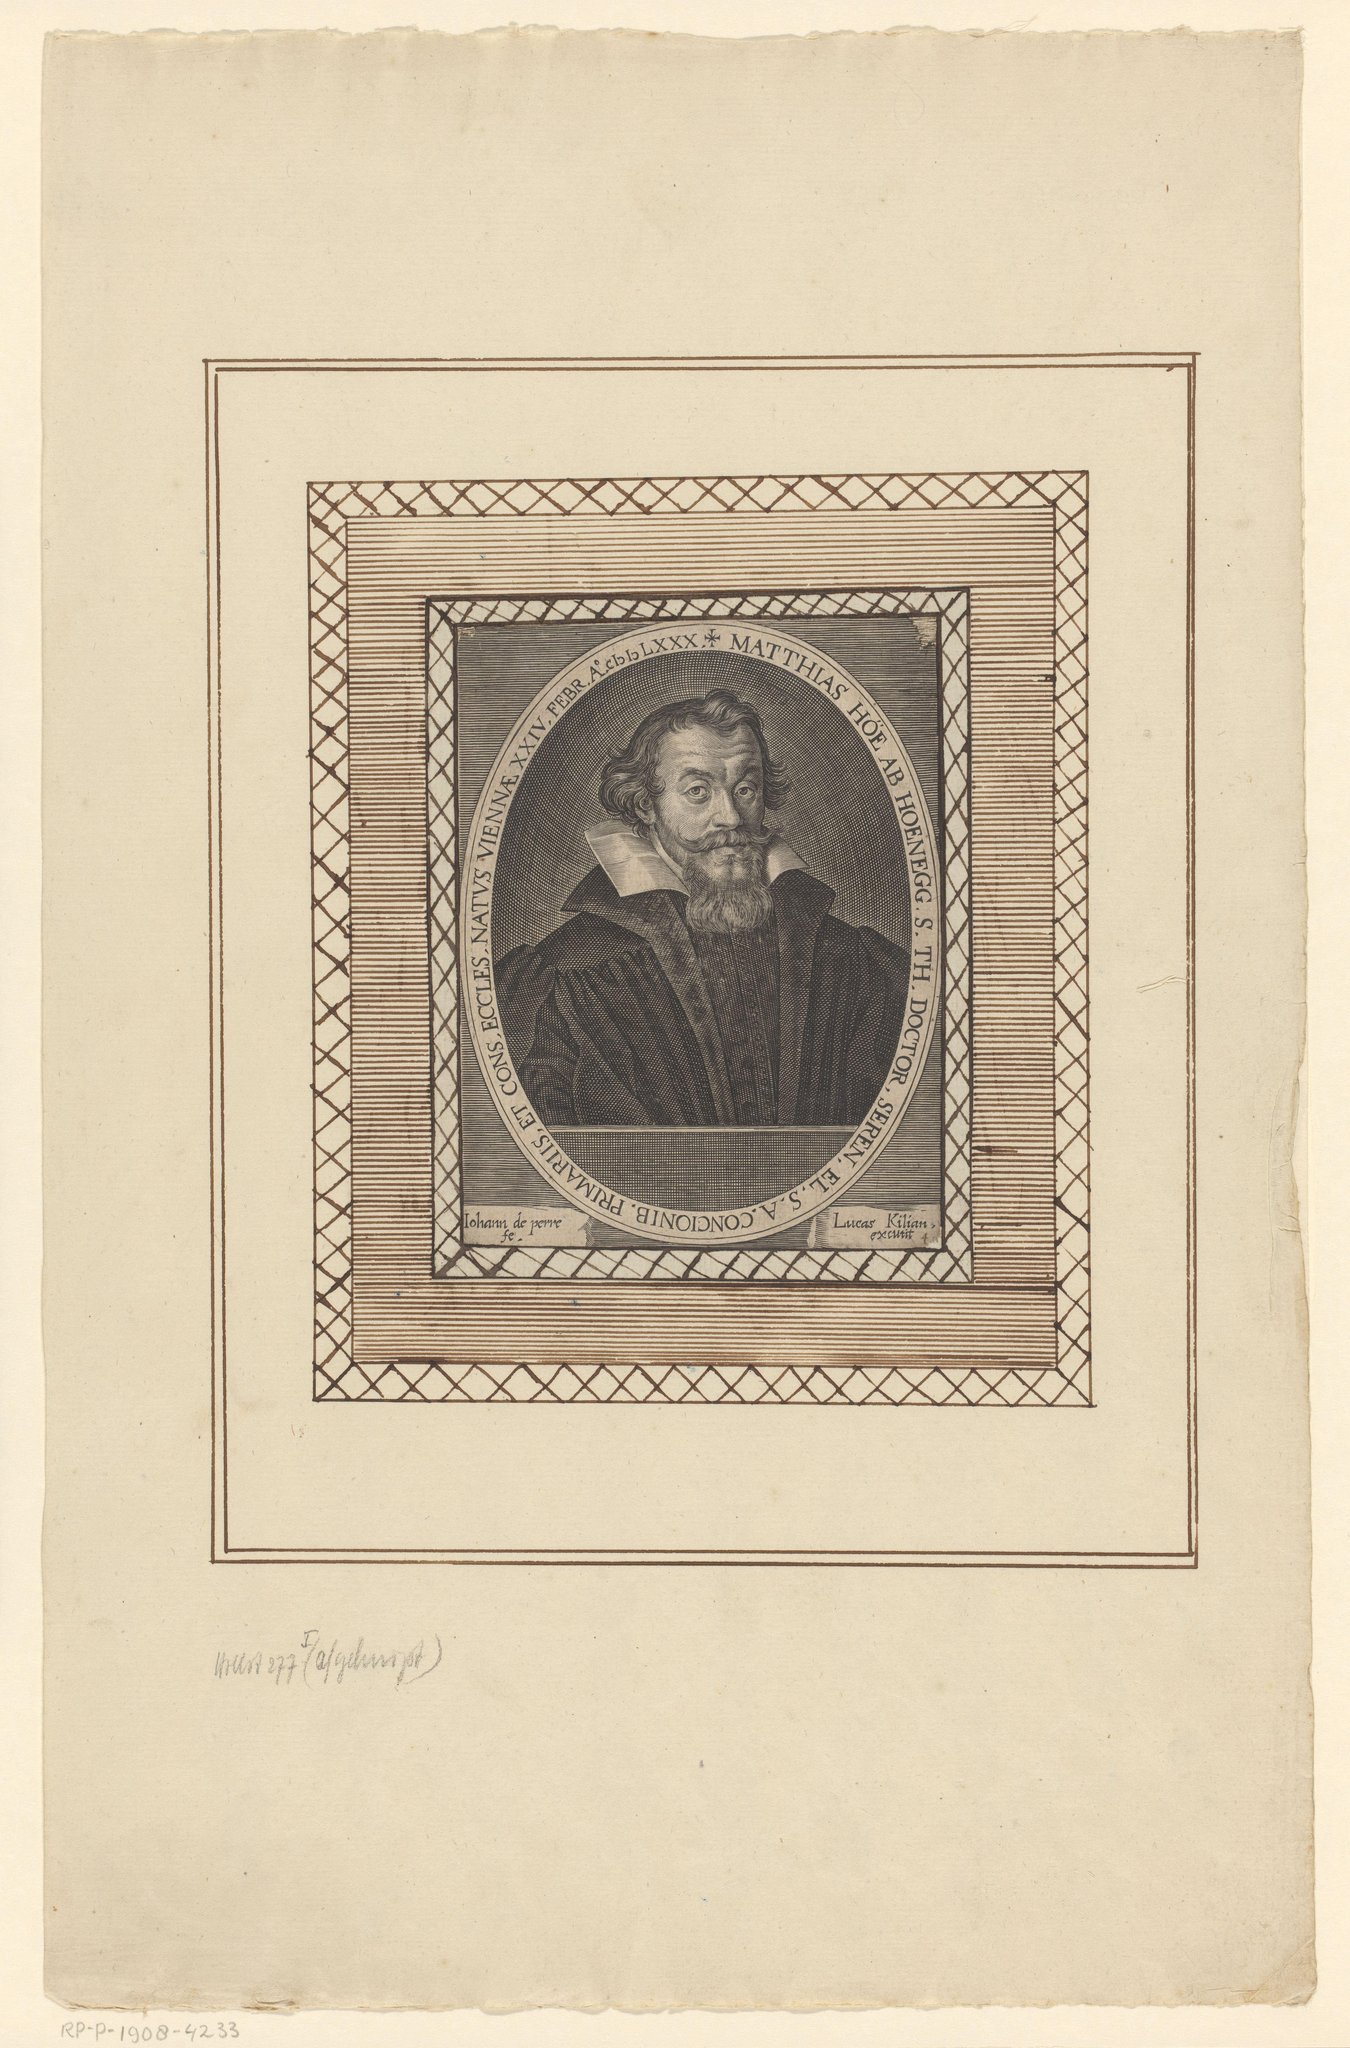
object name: print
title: Portret van Matthias Hoë van Hoënegg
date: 1621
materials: ink, paper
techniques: engraving, pen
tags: vienna, theologian, historical persons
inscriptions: collector's mark: Lugt 2228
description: Tekst in het Latijn in de omlijsting. Een met de hand getekende omkadering.